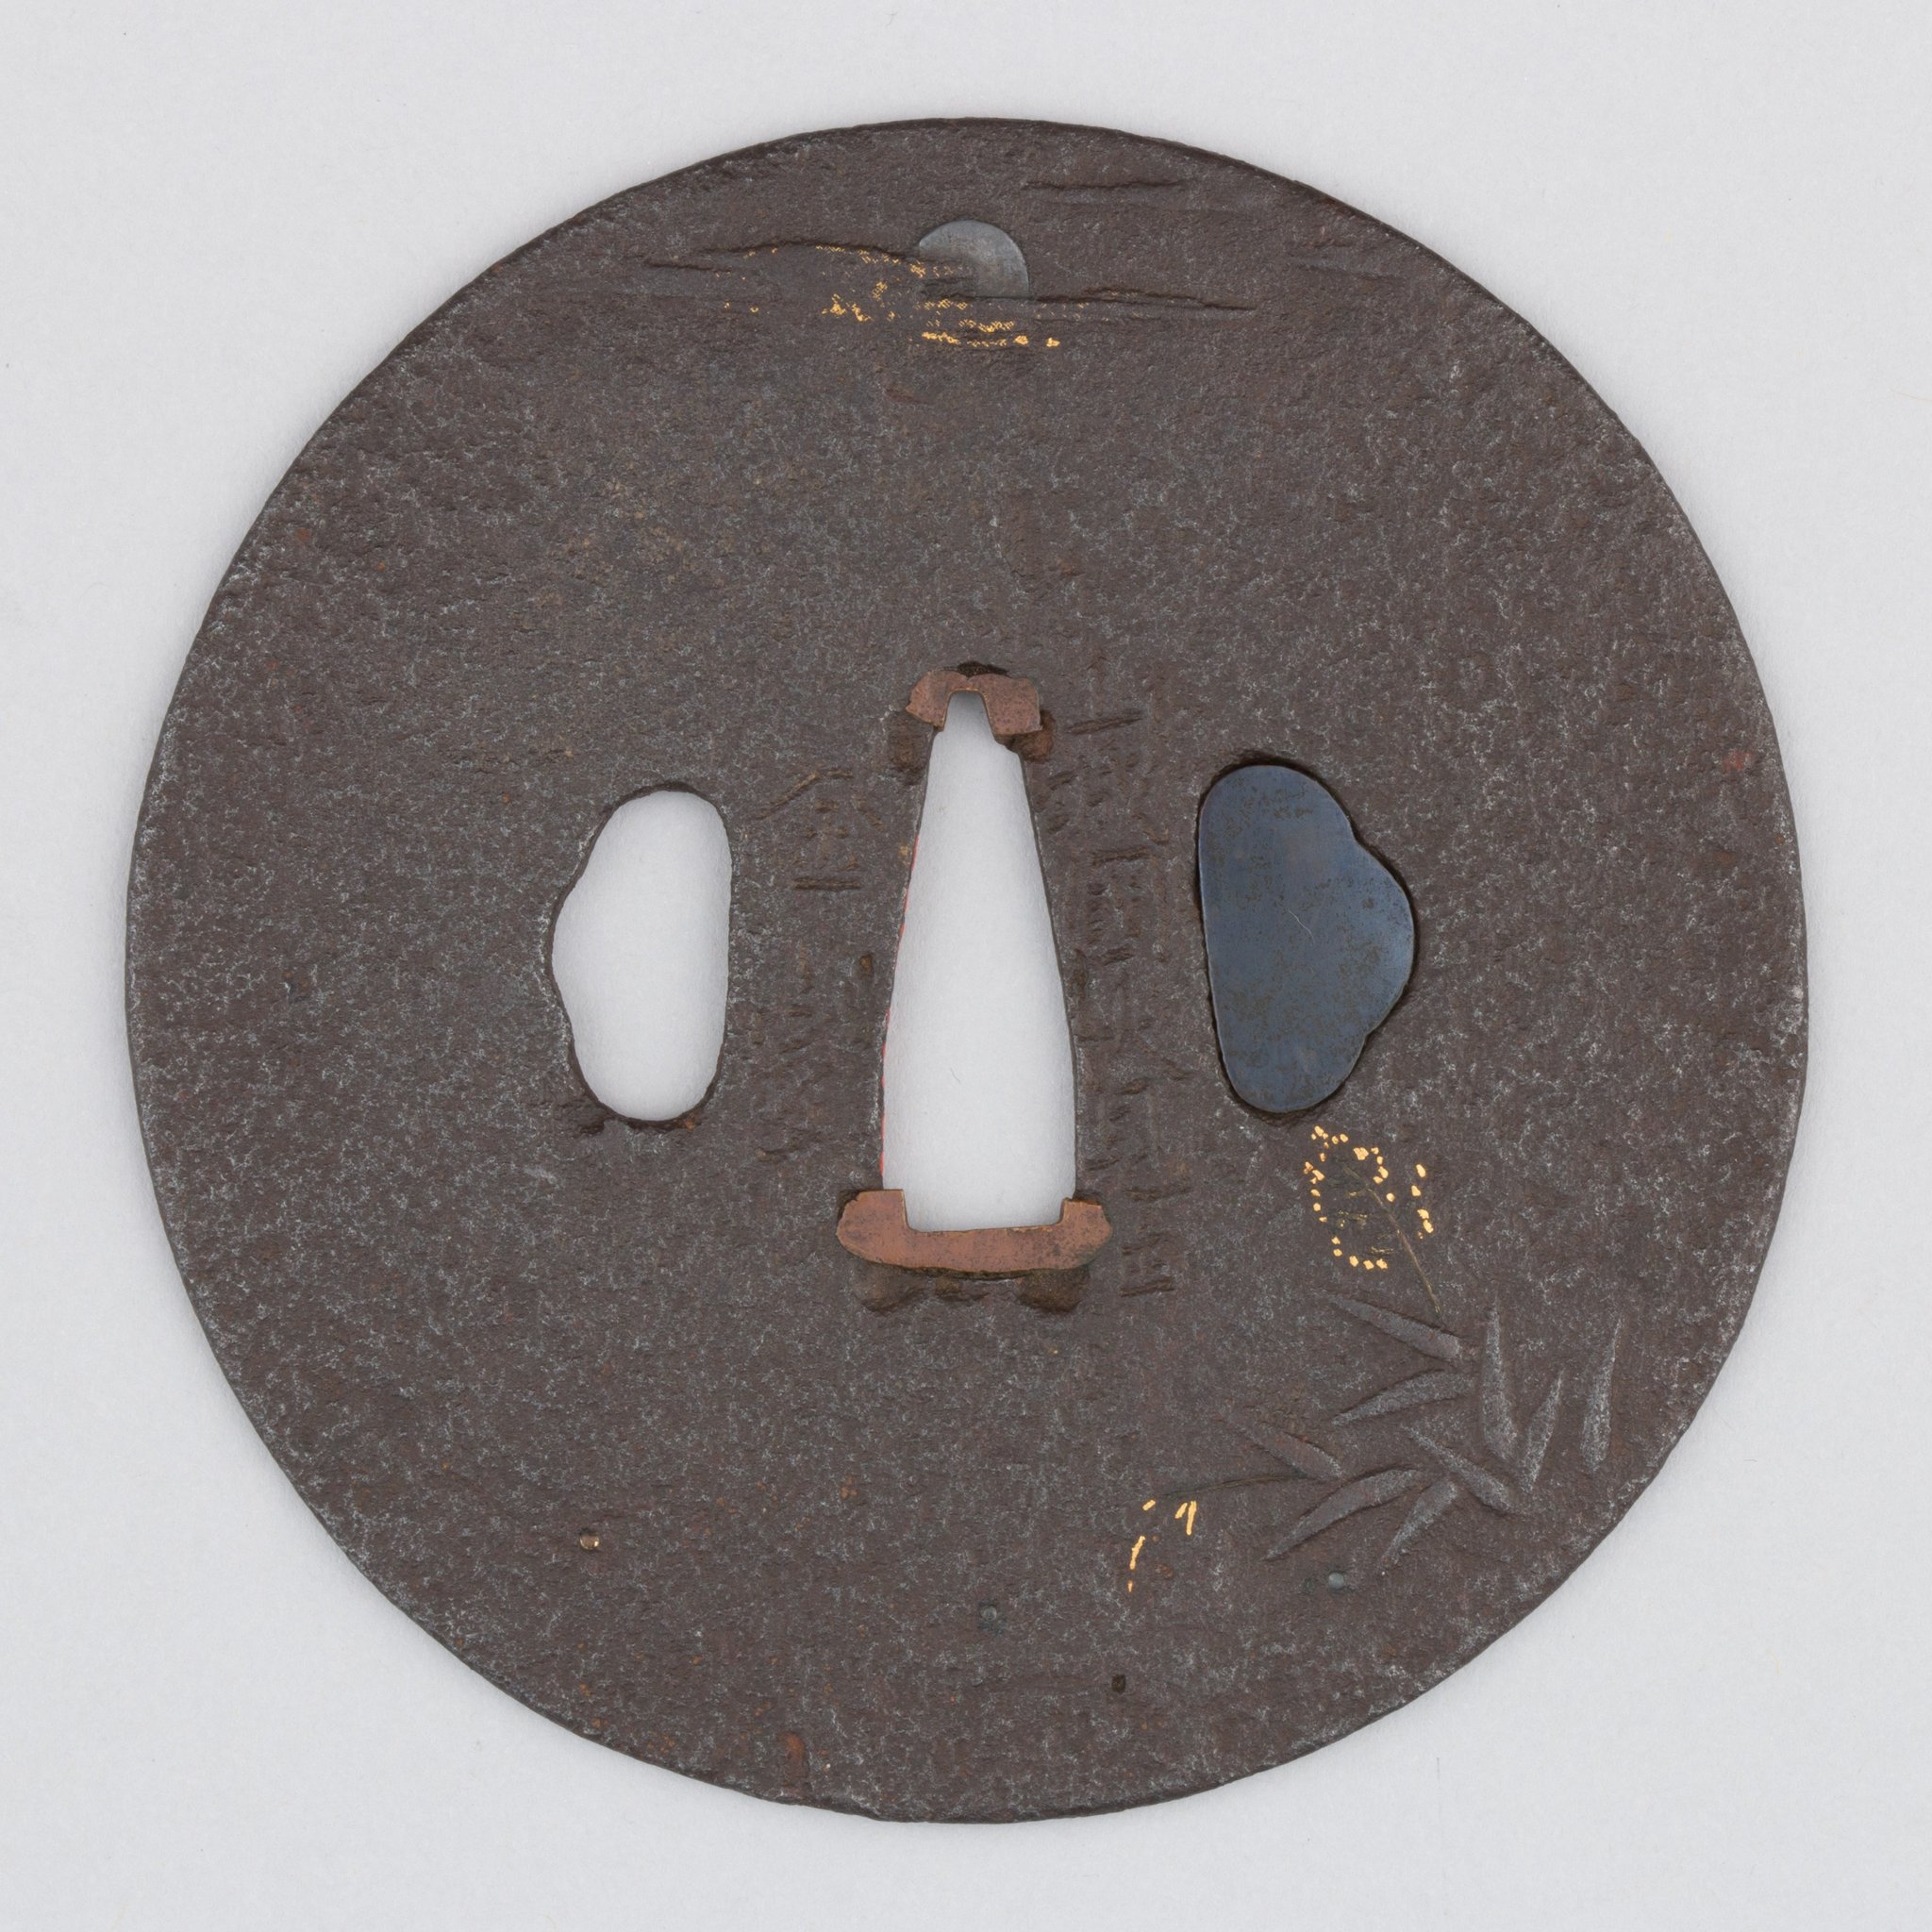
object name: sword guard tsuba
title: Sword Guard (Tsuba)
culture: japanese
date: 1615-1868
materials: copper, gold, iron, silver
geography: japan